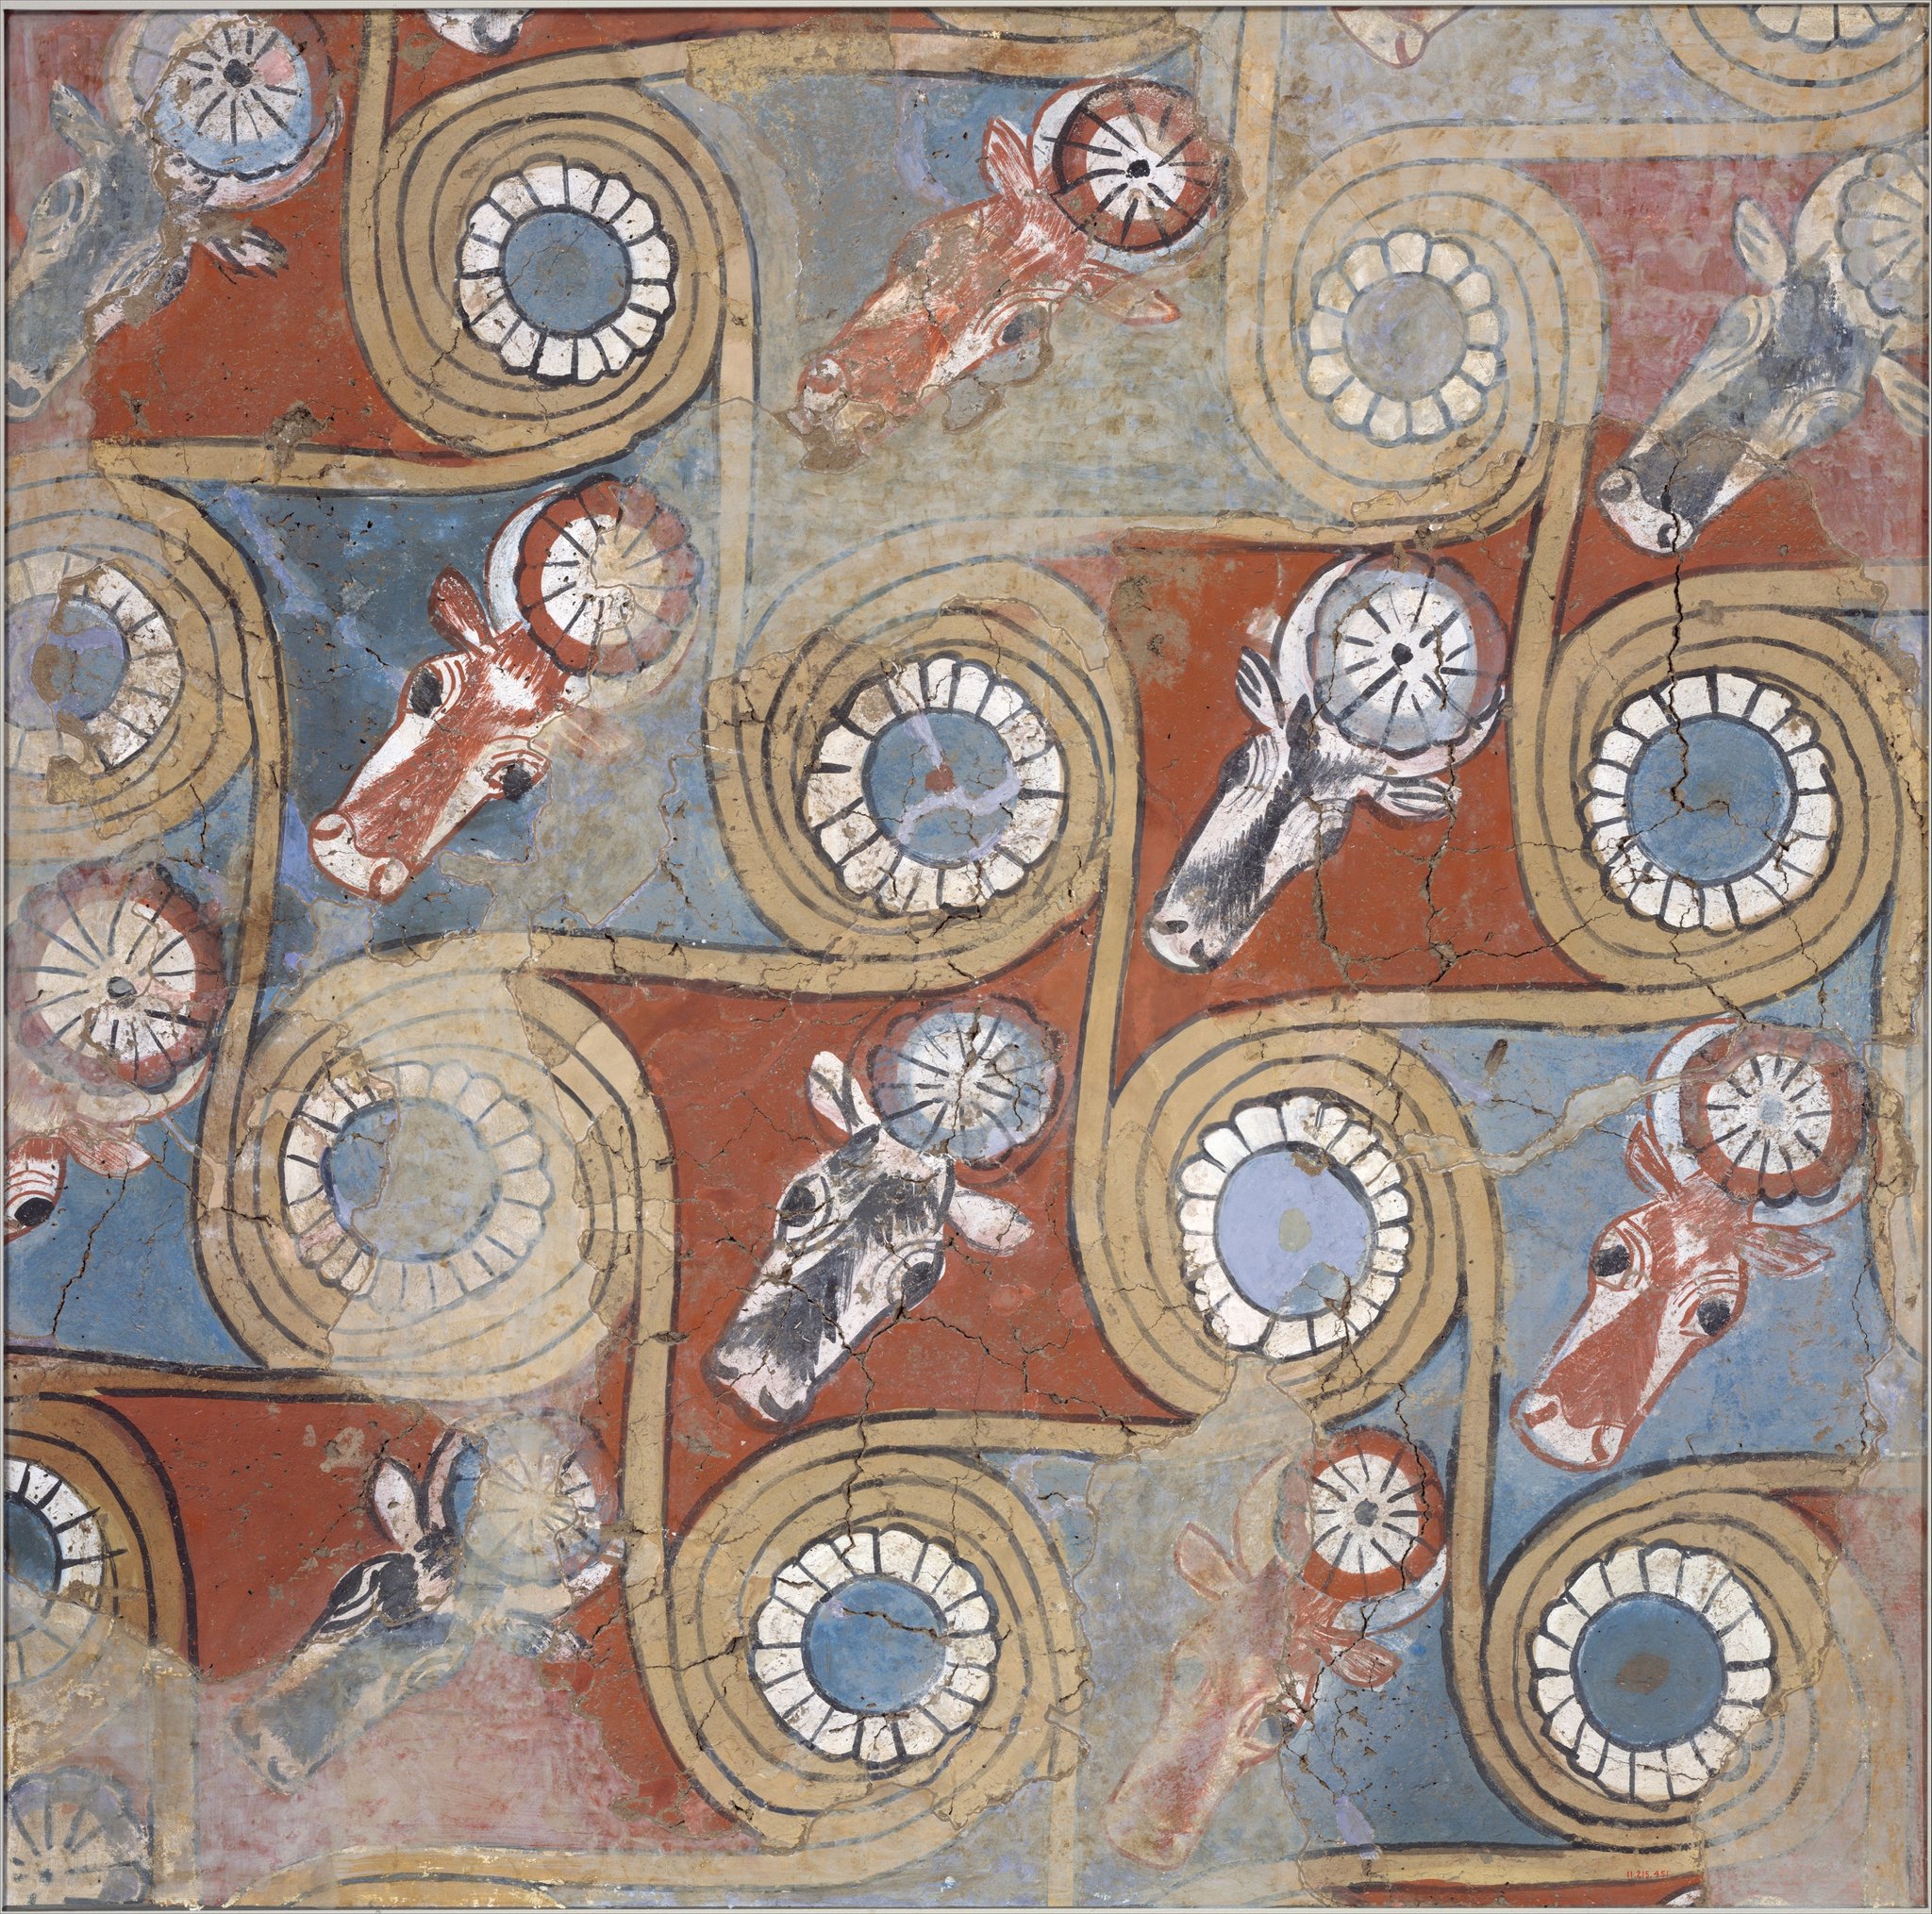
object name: ceiling painting, palace of amenhotep iii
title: Ceiling painting from the palace of Amenhotep III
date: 1390-1352 BCE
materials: gesso, mud, paint, plaster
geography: egypt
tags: ox